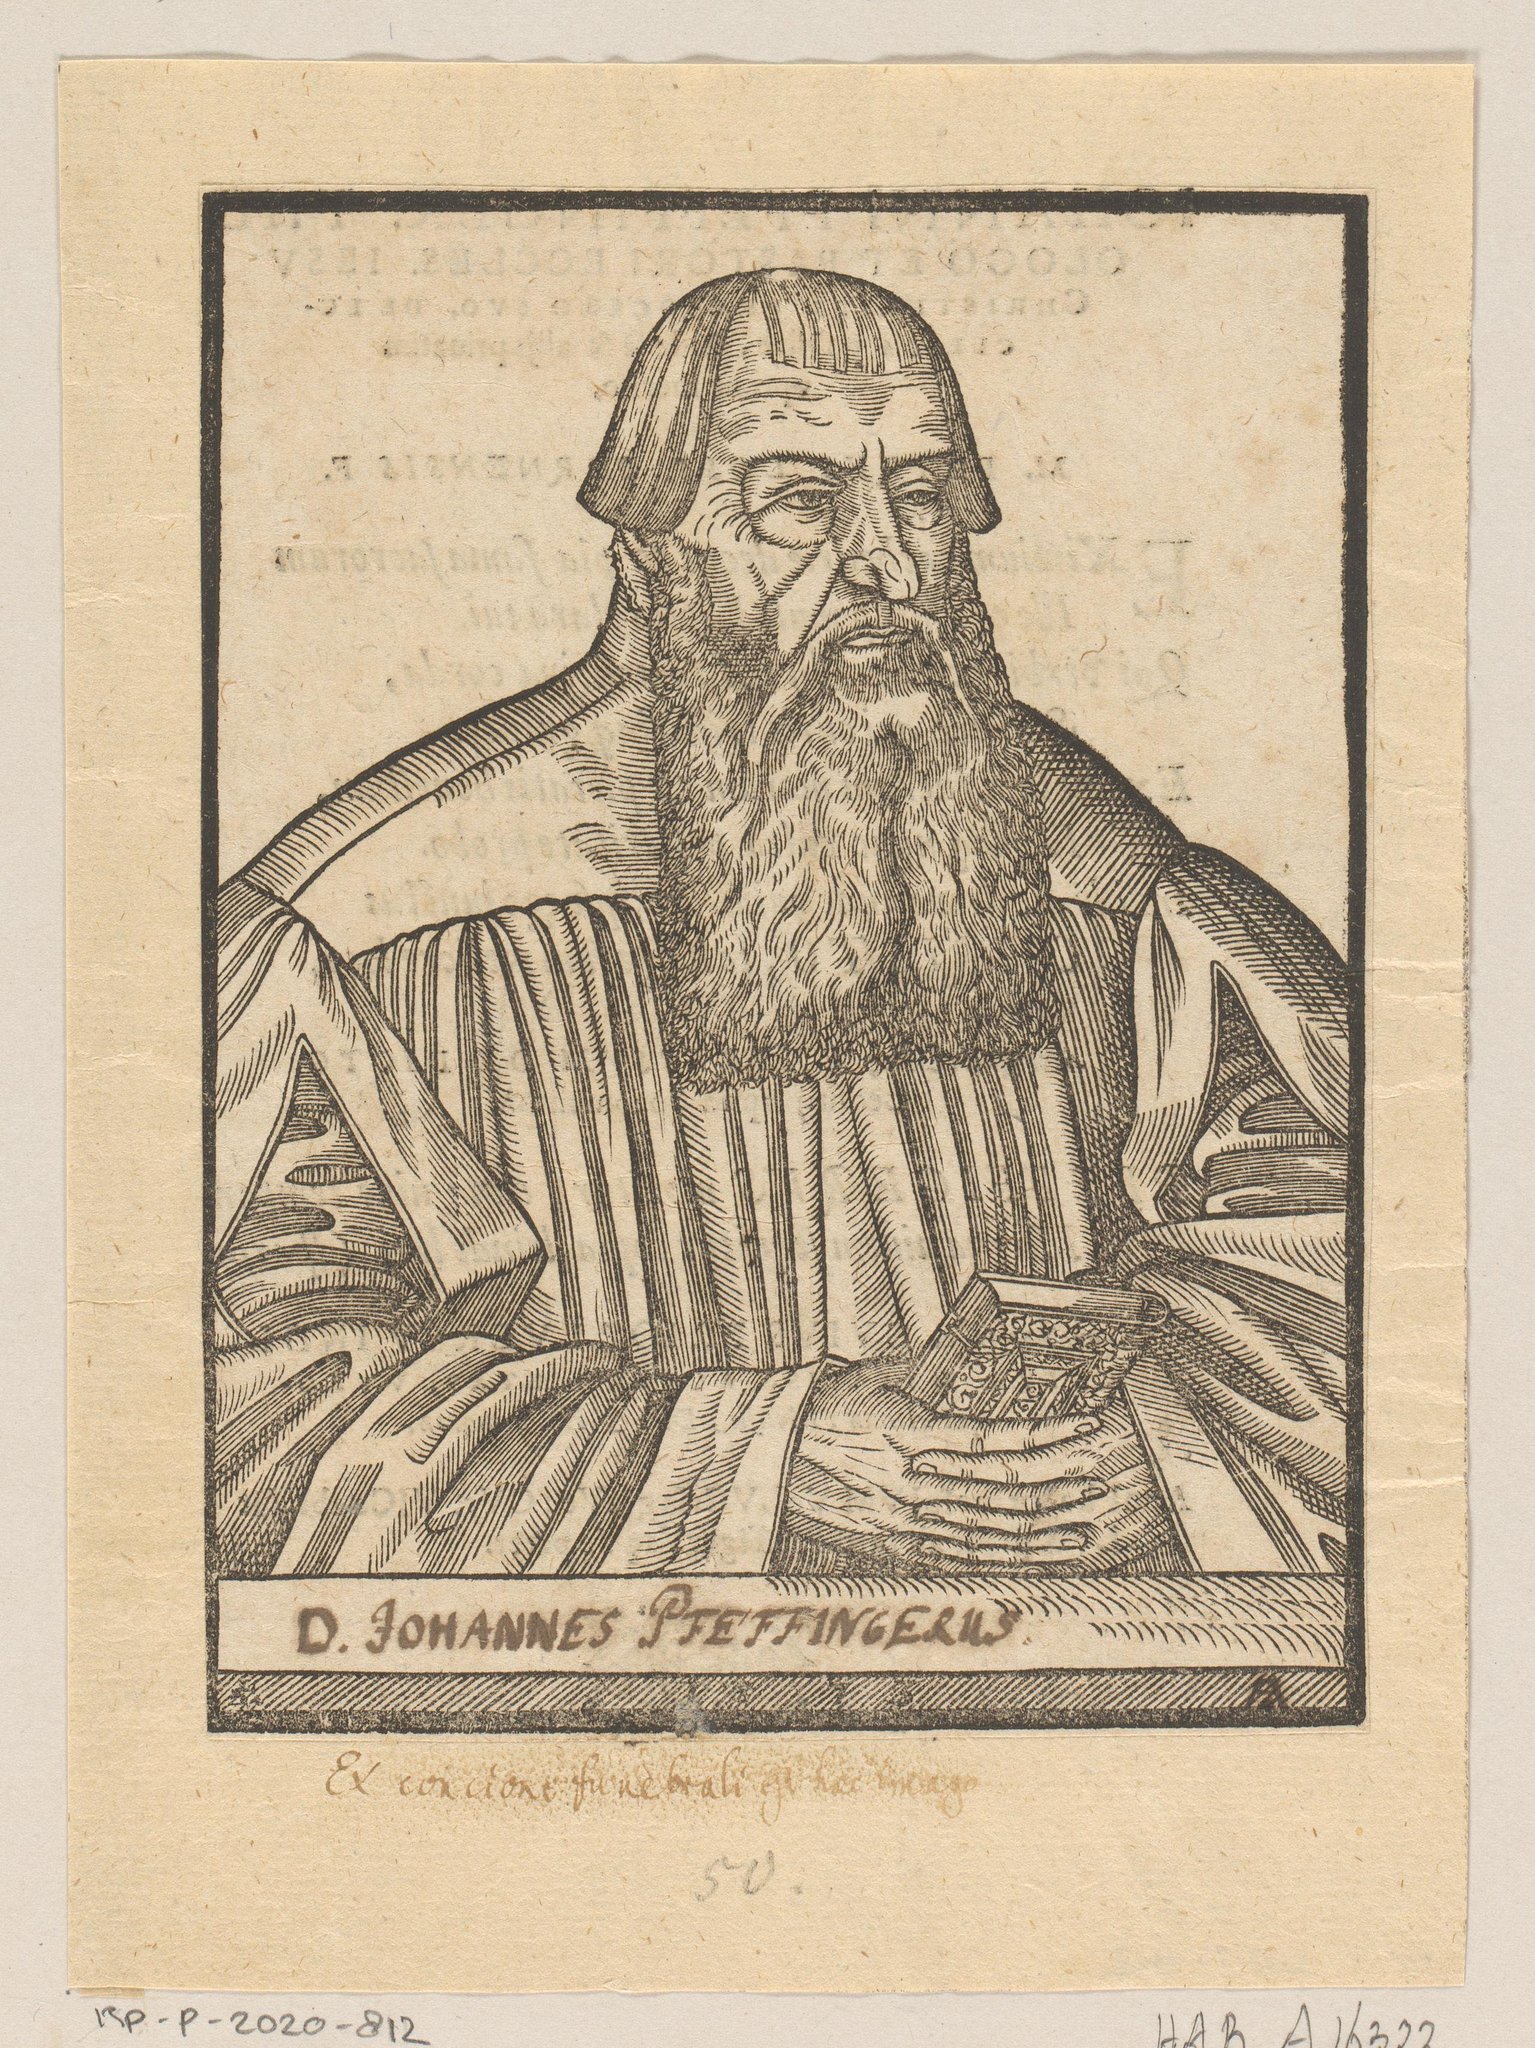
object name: print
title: Portret van Johann Pfeffinger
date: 1571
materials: paper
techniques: letterpress printing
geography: dresden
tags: theologian, historical persons, book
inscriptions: inscription: ‘D. Johannes Pfeffingerus’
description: Prent uit: Kurtze Christliche und Einfeltige widerholung der Bekentnis, der Kirchen (...). Dresden: Matthes Stöckel en Gimel Bergen, 1571. Prent mogelijk ook gebruikt in andere publicaties.